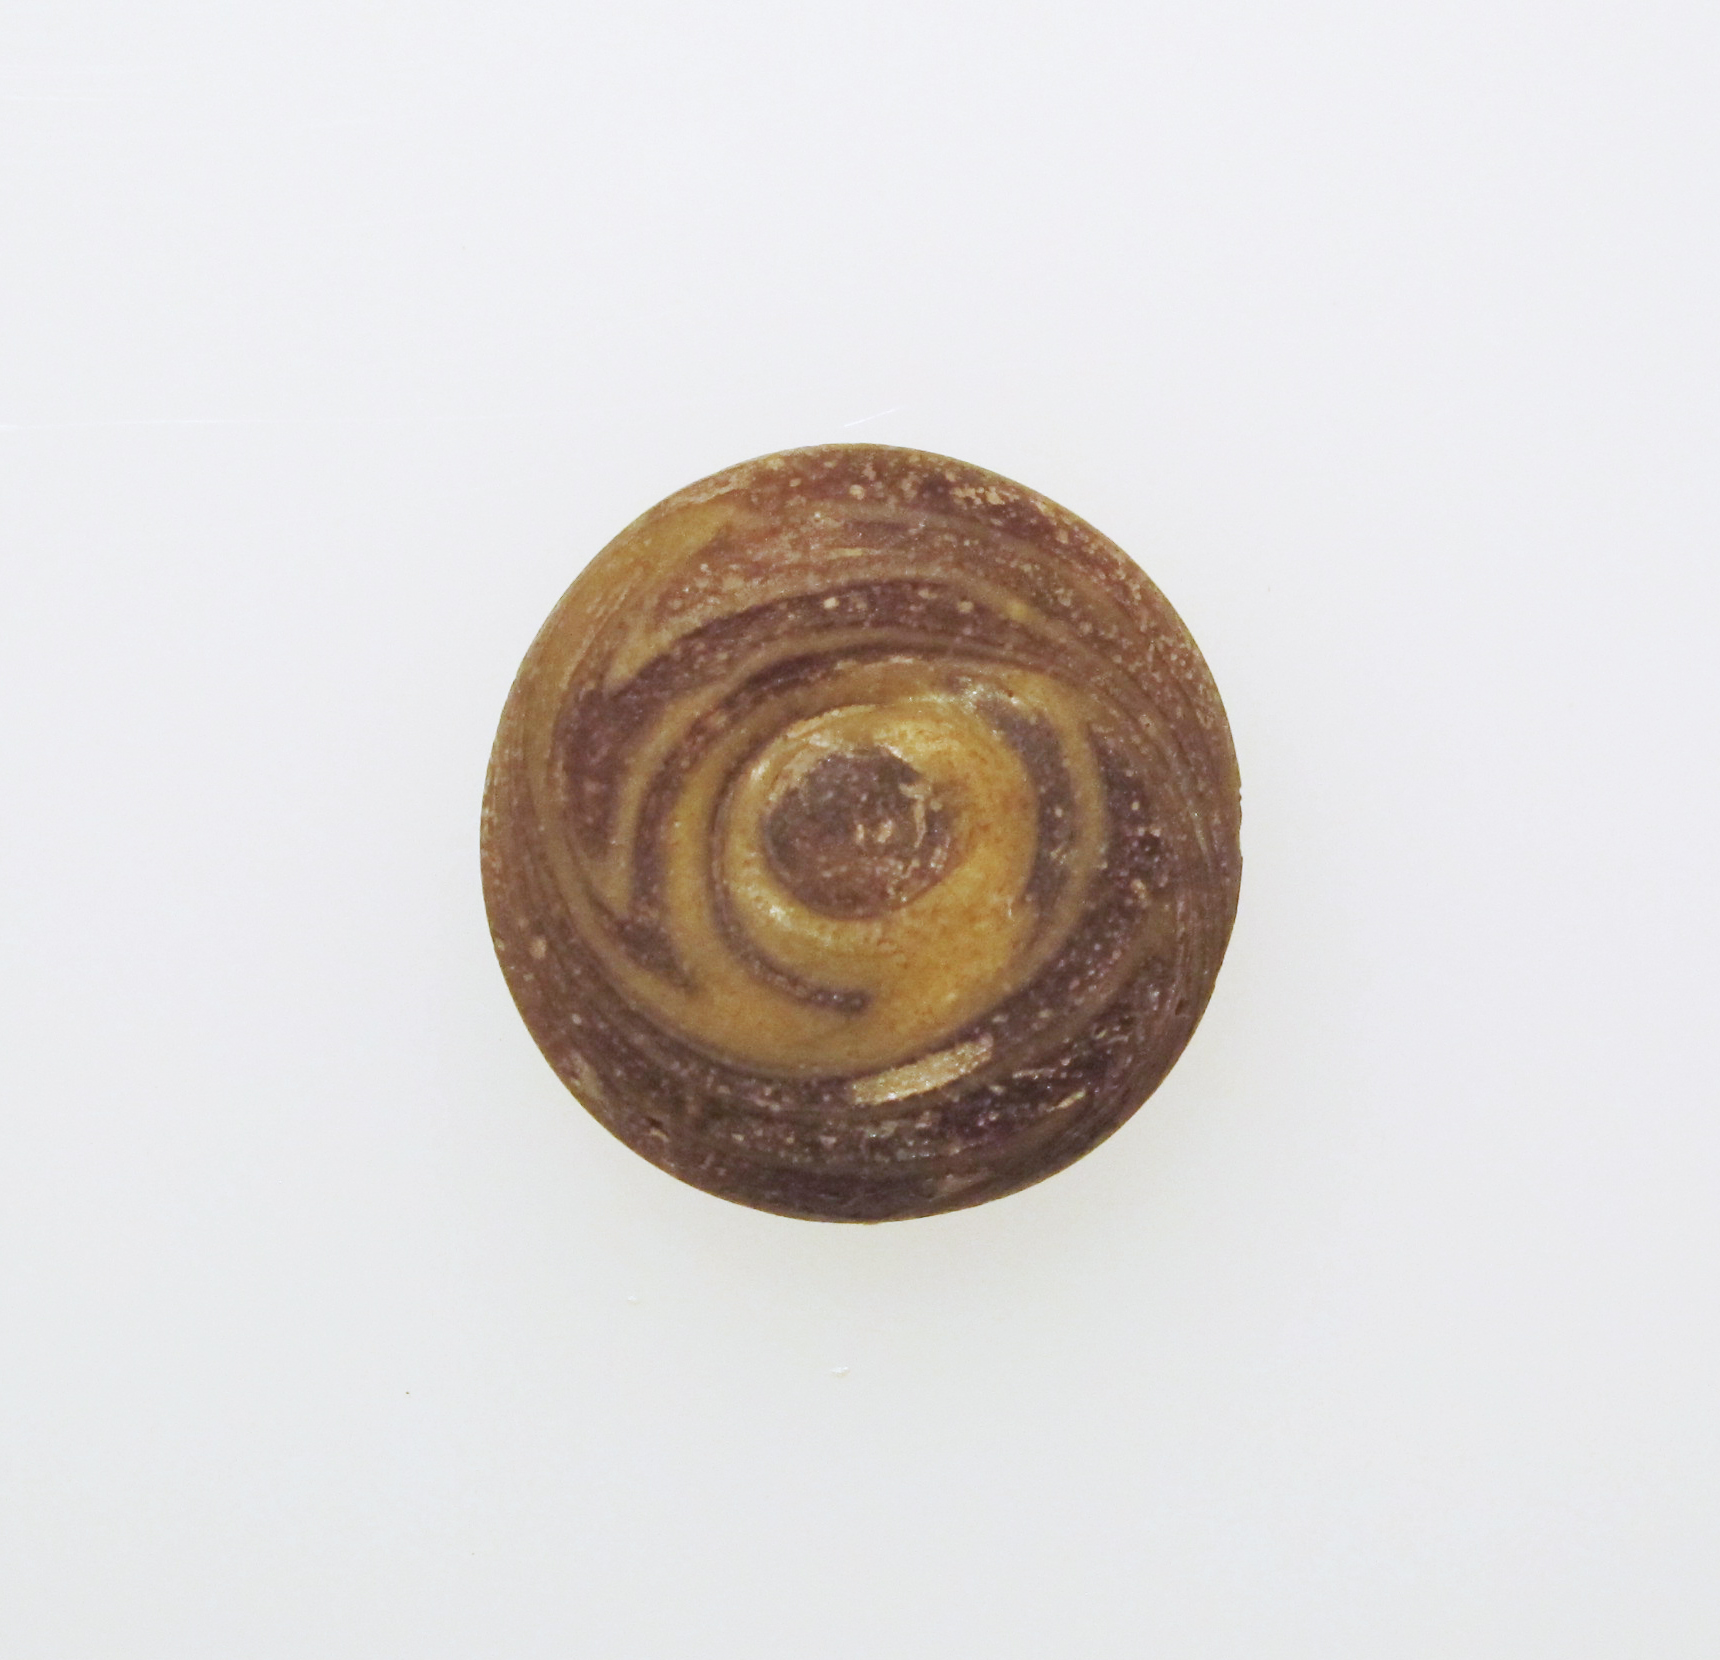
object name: pinhead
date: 7000 BCE-330 CE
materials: glass